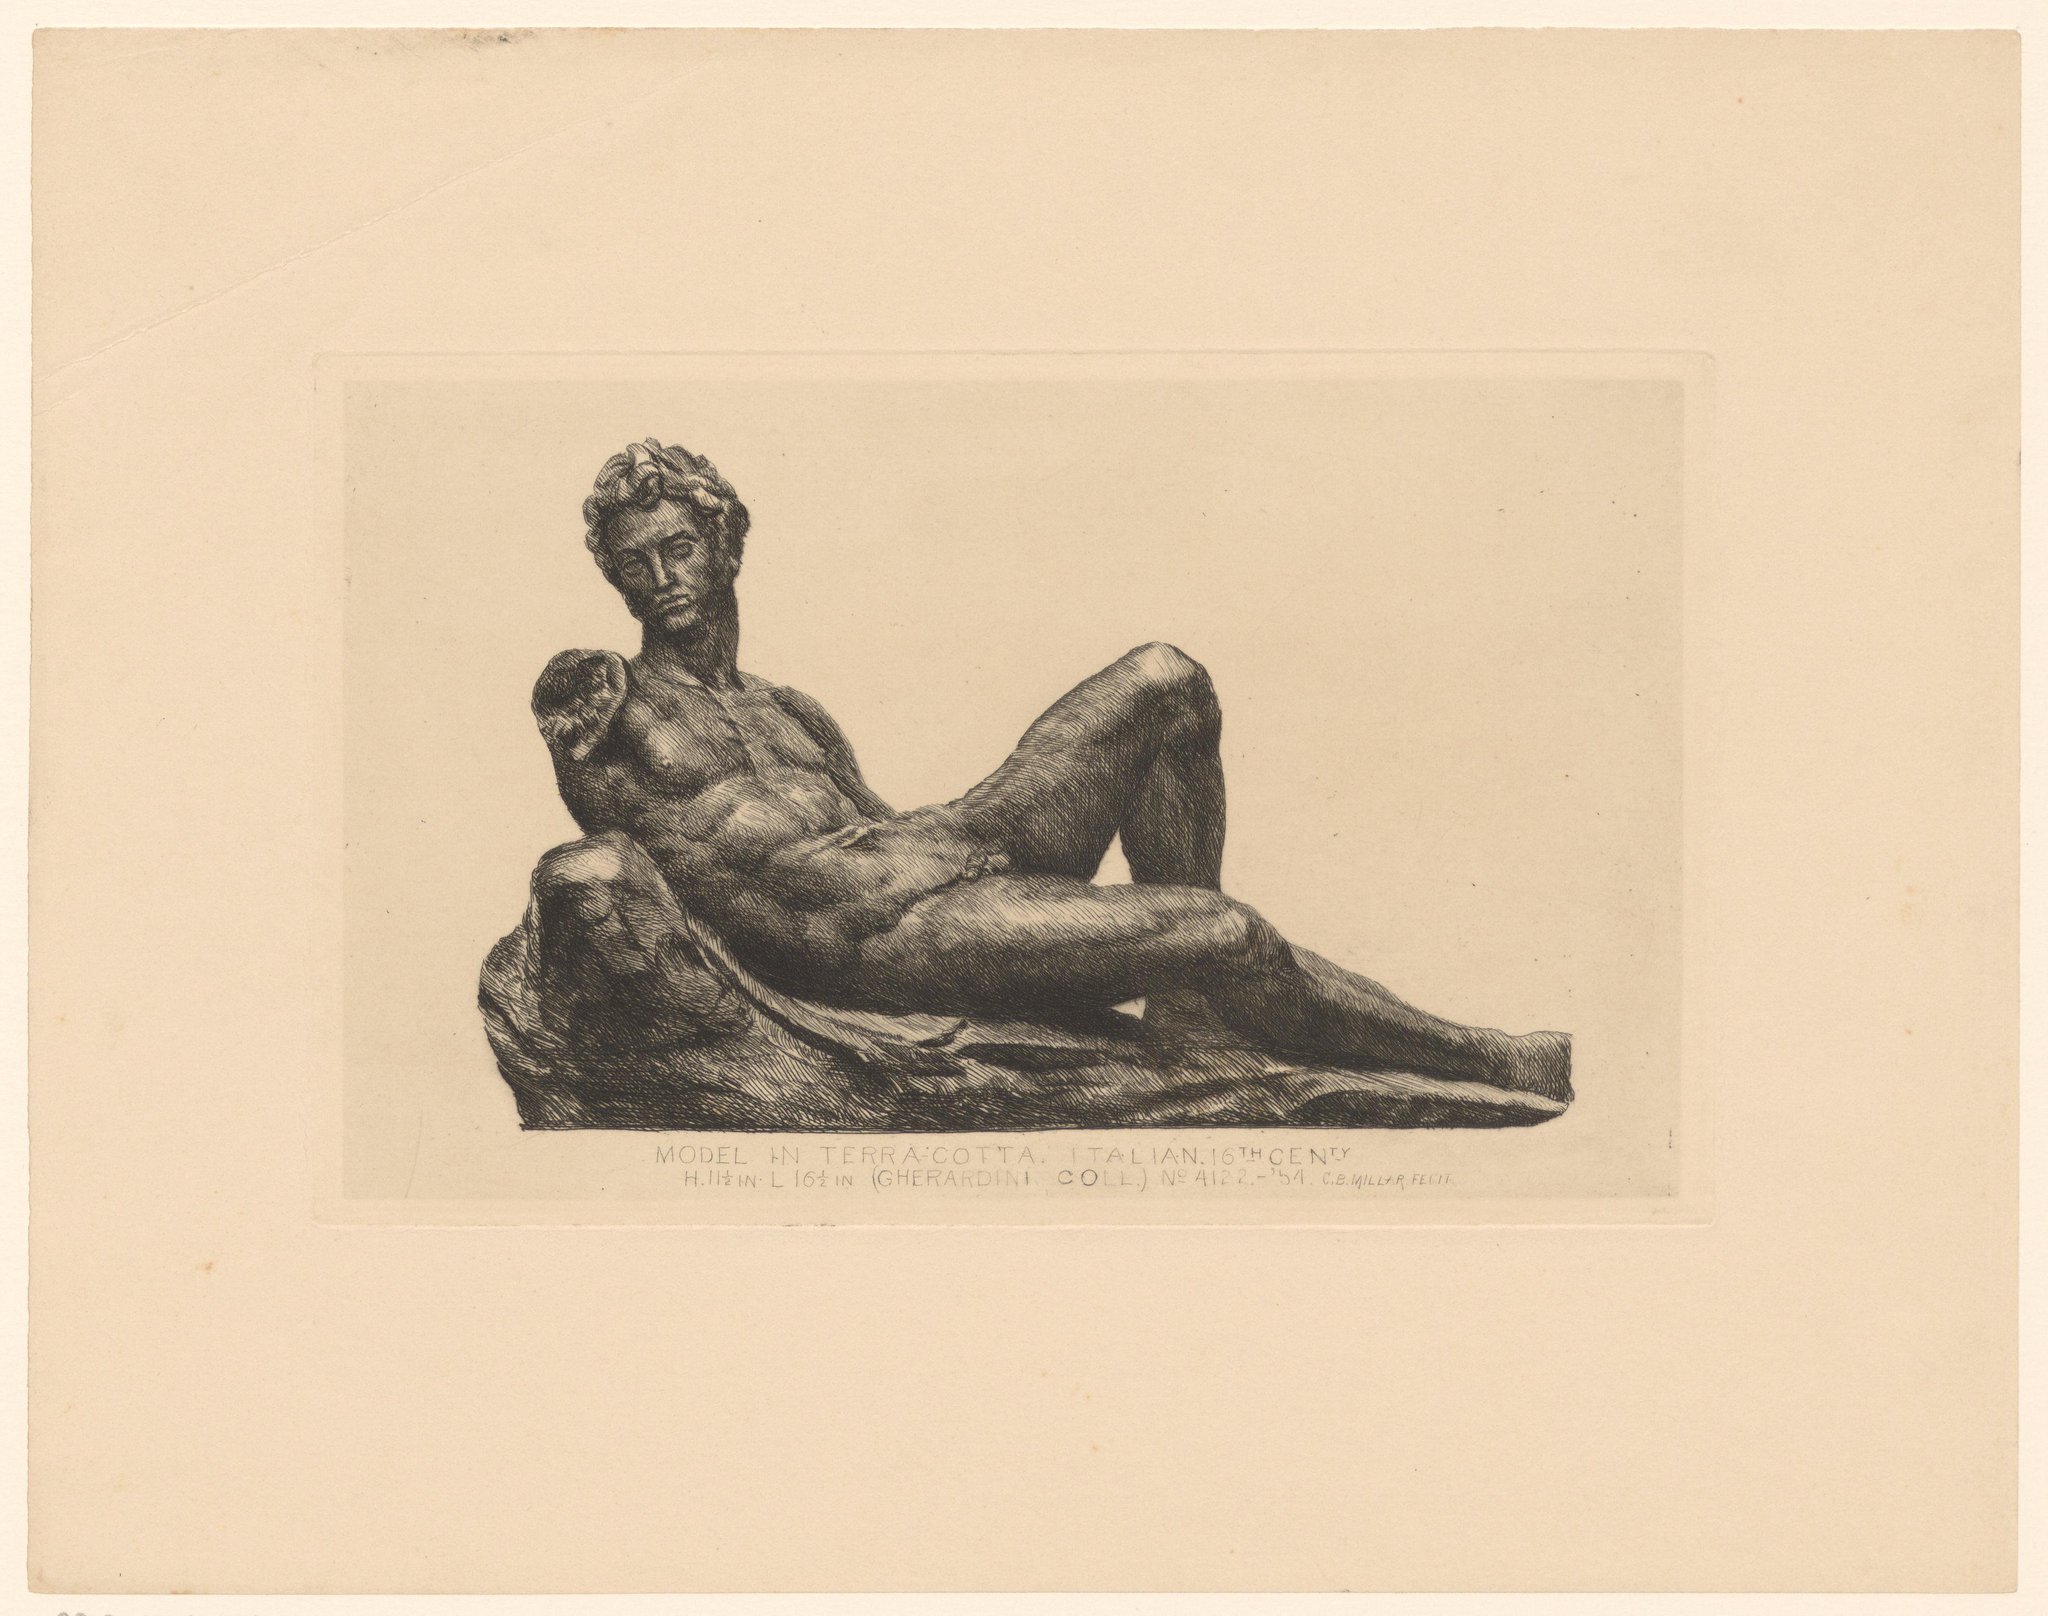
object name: print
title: Liggend mannelijk naakt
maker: c.b. millar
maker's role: print maker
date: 1876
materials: paper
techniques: drypoint, etching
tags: lying on the back with uplifted upper part of the body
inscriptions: collector's mark: Lugt 2228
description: Prent is deel van een groep prenten gemaakt door leerlingen van Alphonse Legros, naar kunstwerken in het Victoria & Albert Museum.